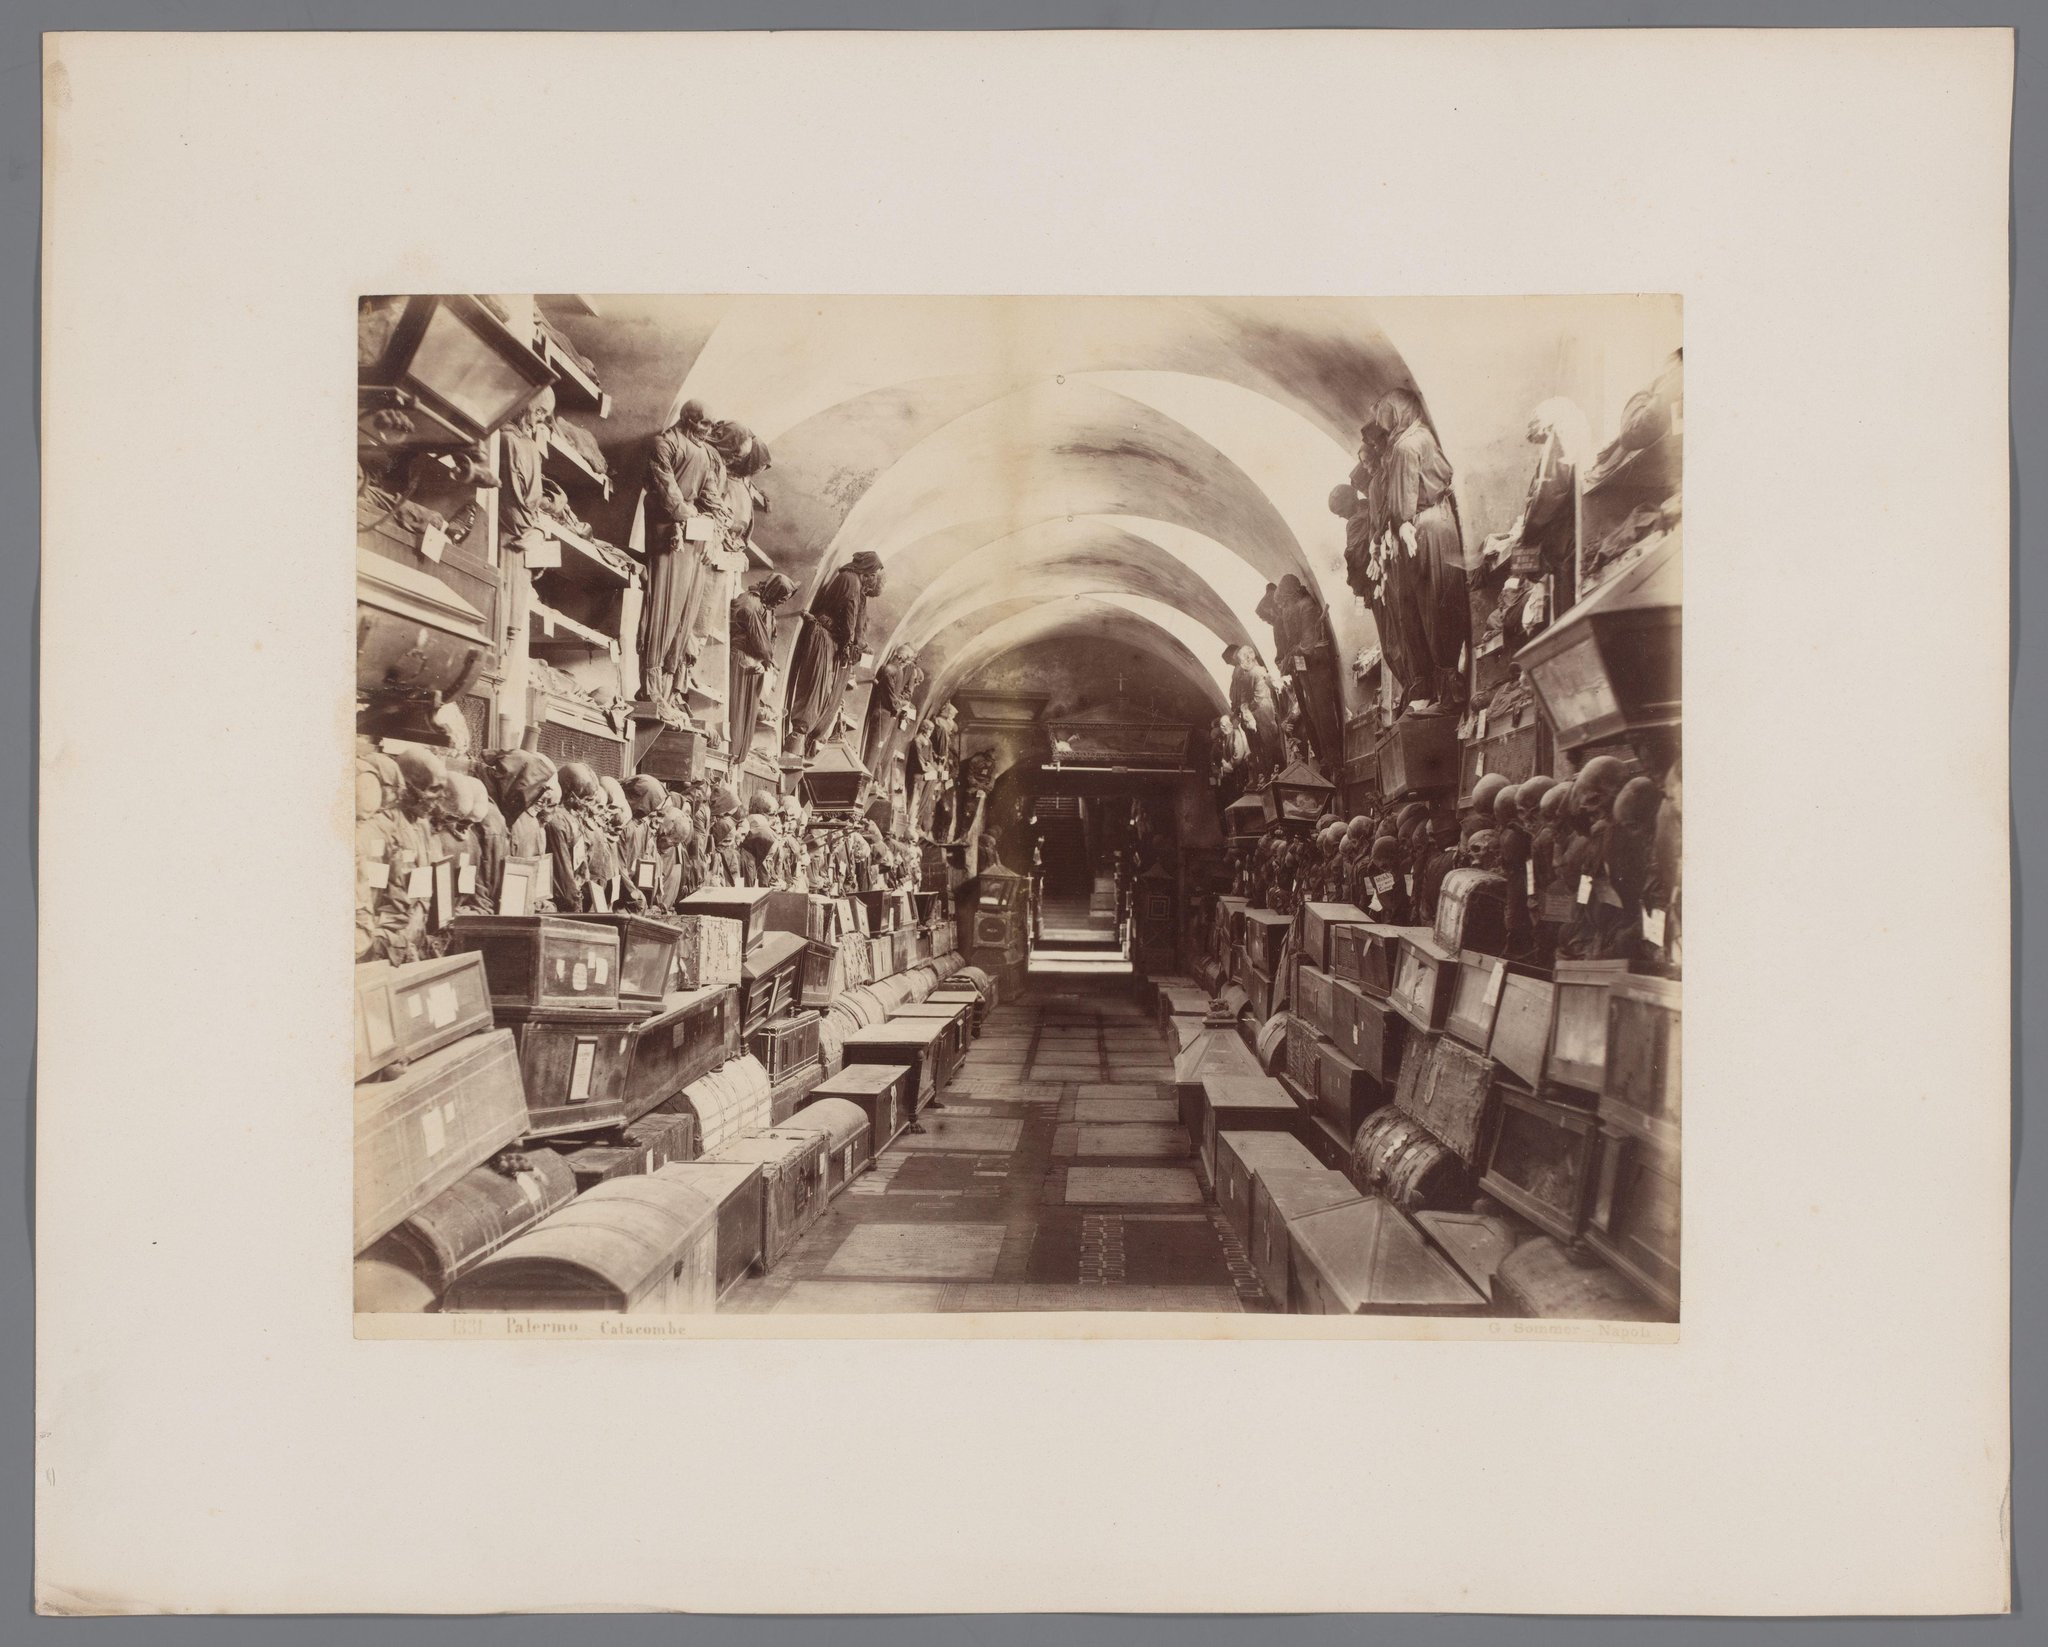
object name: photograph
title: Catacombe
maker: giorgio sommer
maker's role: fotograaf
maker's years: 1834-1914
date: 1857-1914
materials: cardboard, paper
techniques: albumen print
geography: palermo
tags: catacombs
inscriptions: number: ‘1331’